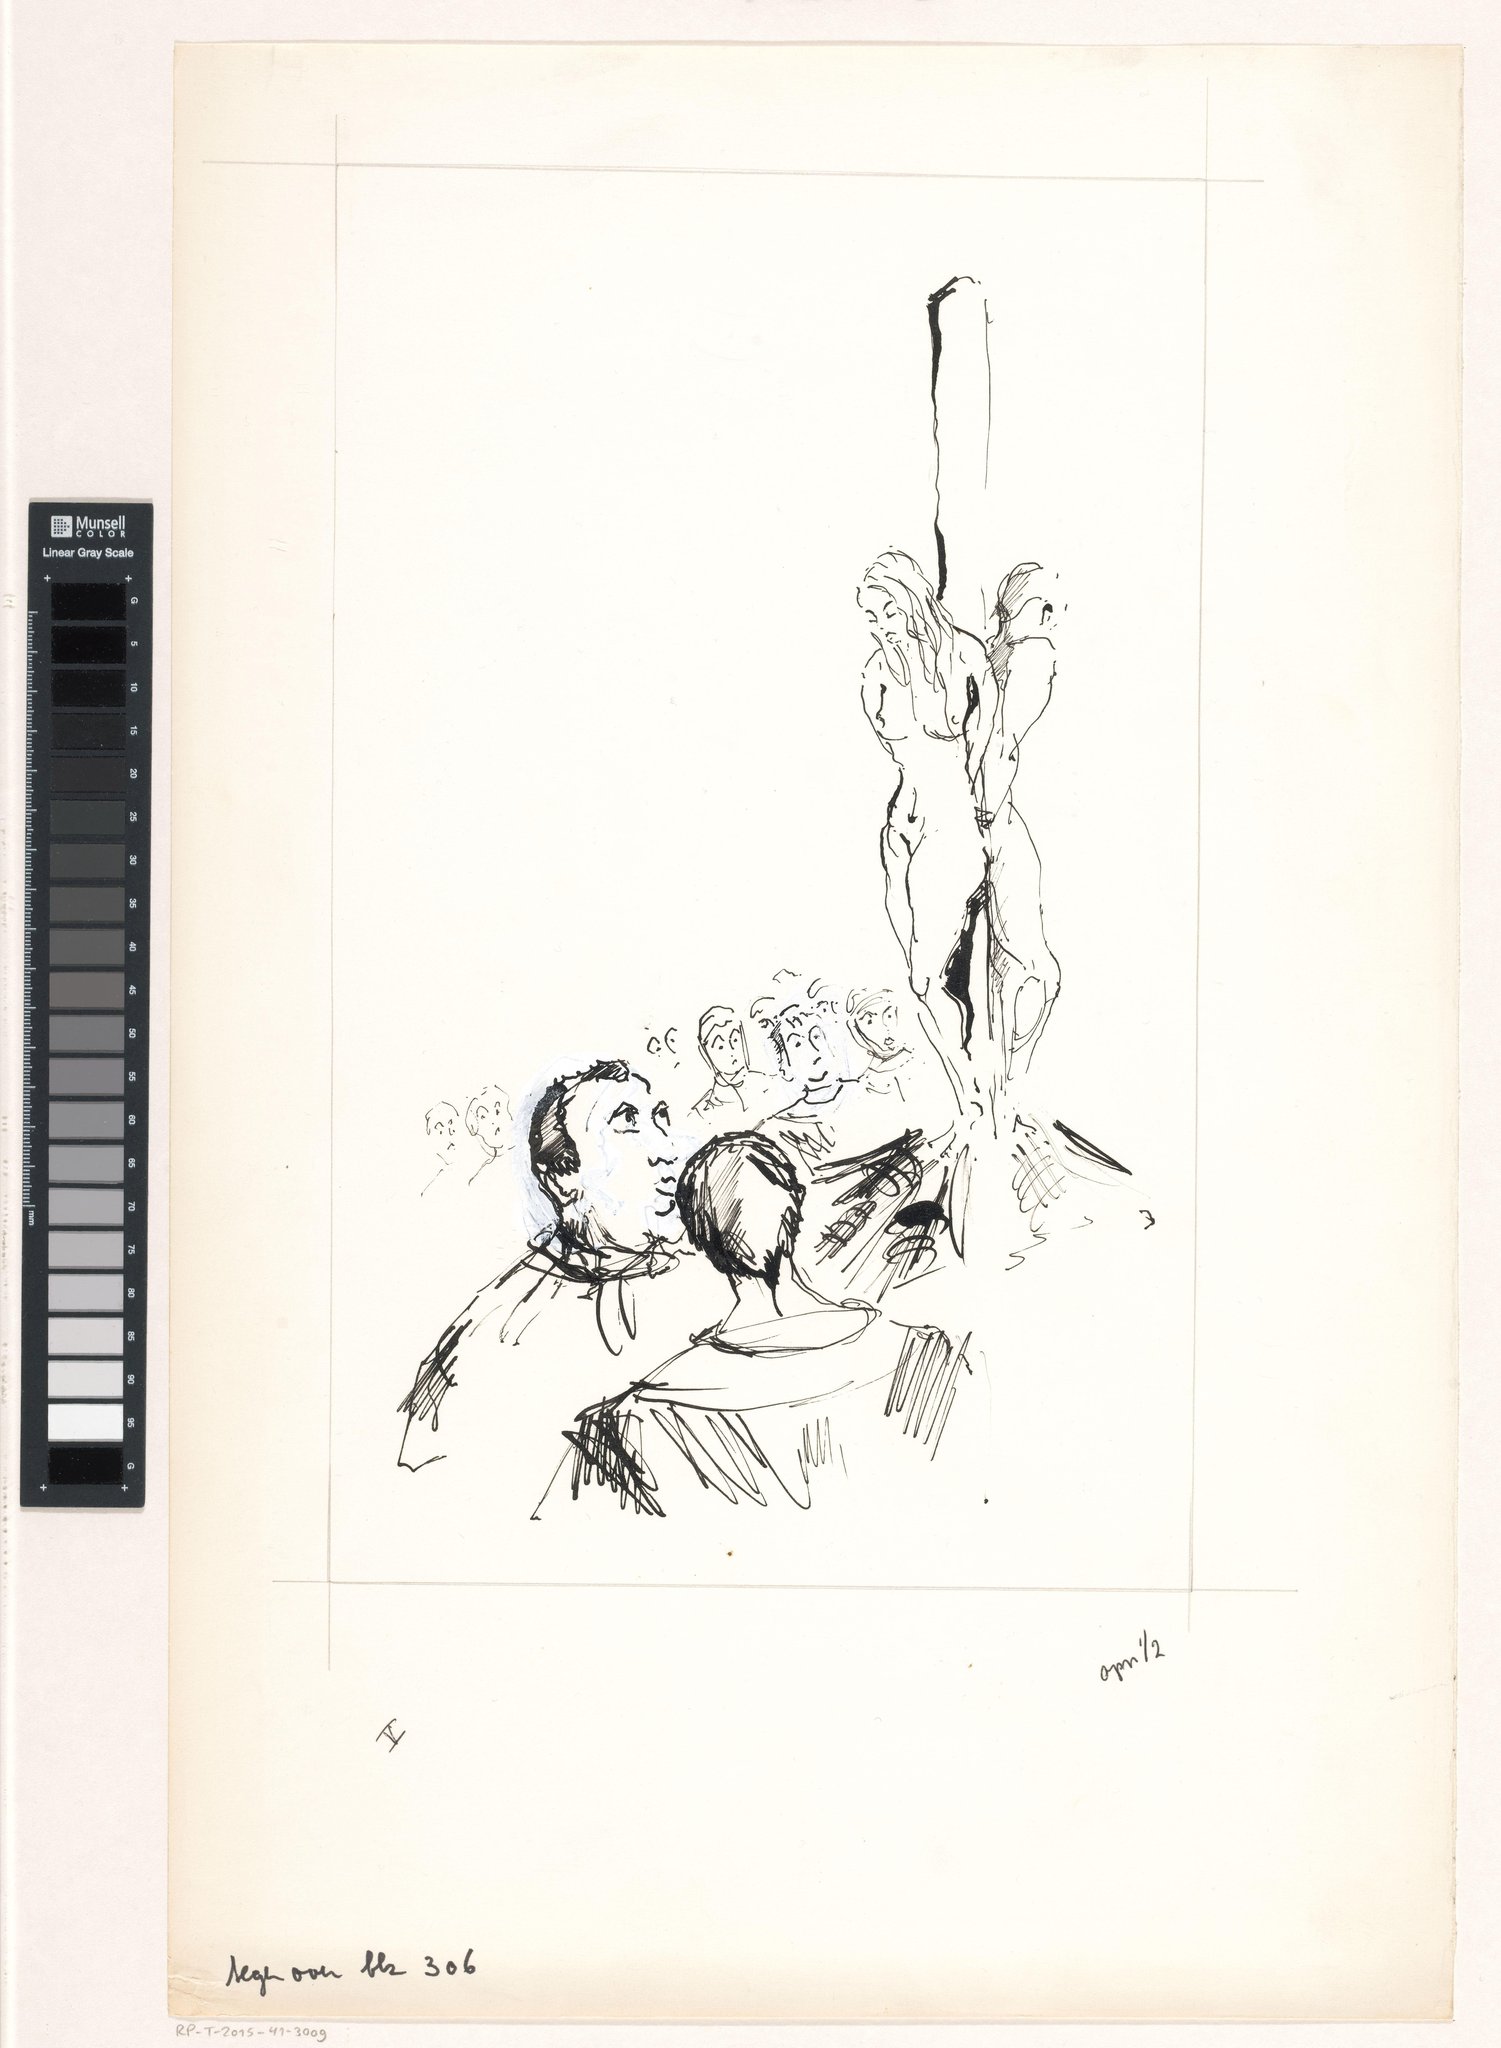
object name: boekillustratie ontwerp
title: Vrouwen op een brandstapel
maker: Anonymous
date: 1900-1970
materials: paint, ink, paper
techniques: brush, pen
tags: instruments of torture, execution or punishment: stake, the (nude) human figure; 'corpo humano' (ripa) - aa - female human figure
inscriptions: collector's mark: Lugt 2228a, :, annotation: ‘V/ tegen over blz 306’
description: Twee naakte vrouwen staan met de ruggen naar elkaar toe aan een paal vastgebonden op de brandstapel. Een groep toeschouwers heeft zich rond de vrouwen verzameld.